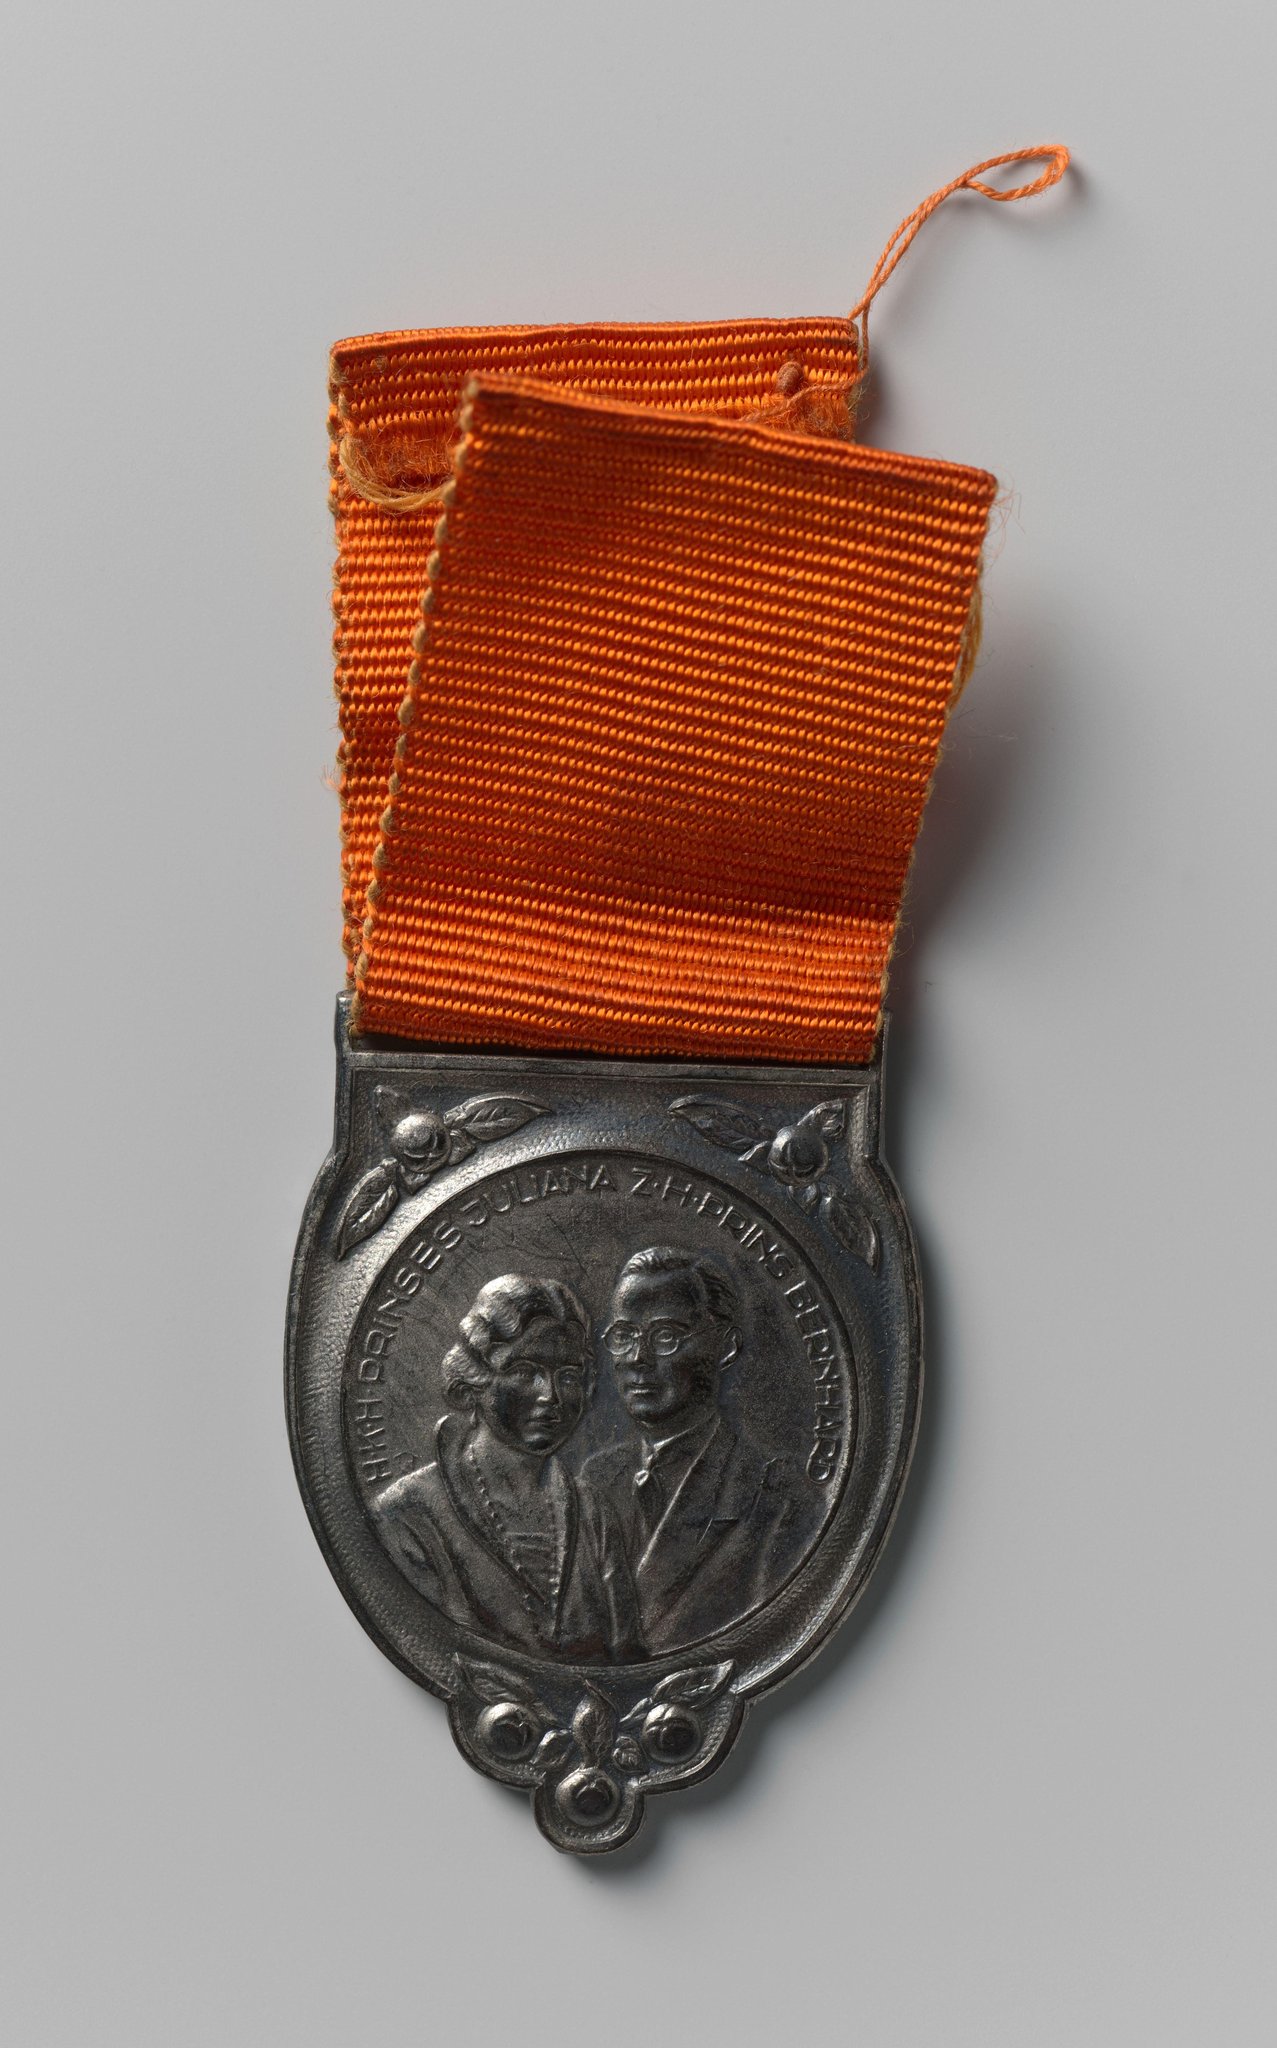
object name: history medal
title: Draagteken op de verloving van Prinses Juliana met Bernhard 1936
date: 1936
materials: textile, metal alloy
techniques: striking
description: Eenzijdig draagteken aan oranje lint, op de voorzijde een medaillon met de elkaar half toegewende borstbeelden van Juliana en Bernhard met bovenaan omschrift, versierd met oranjebloesem.